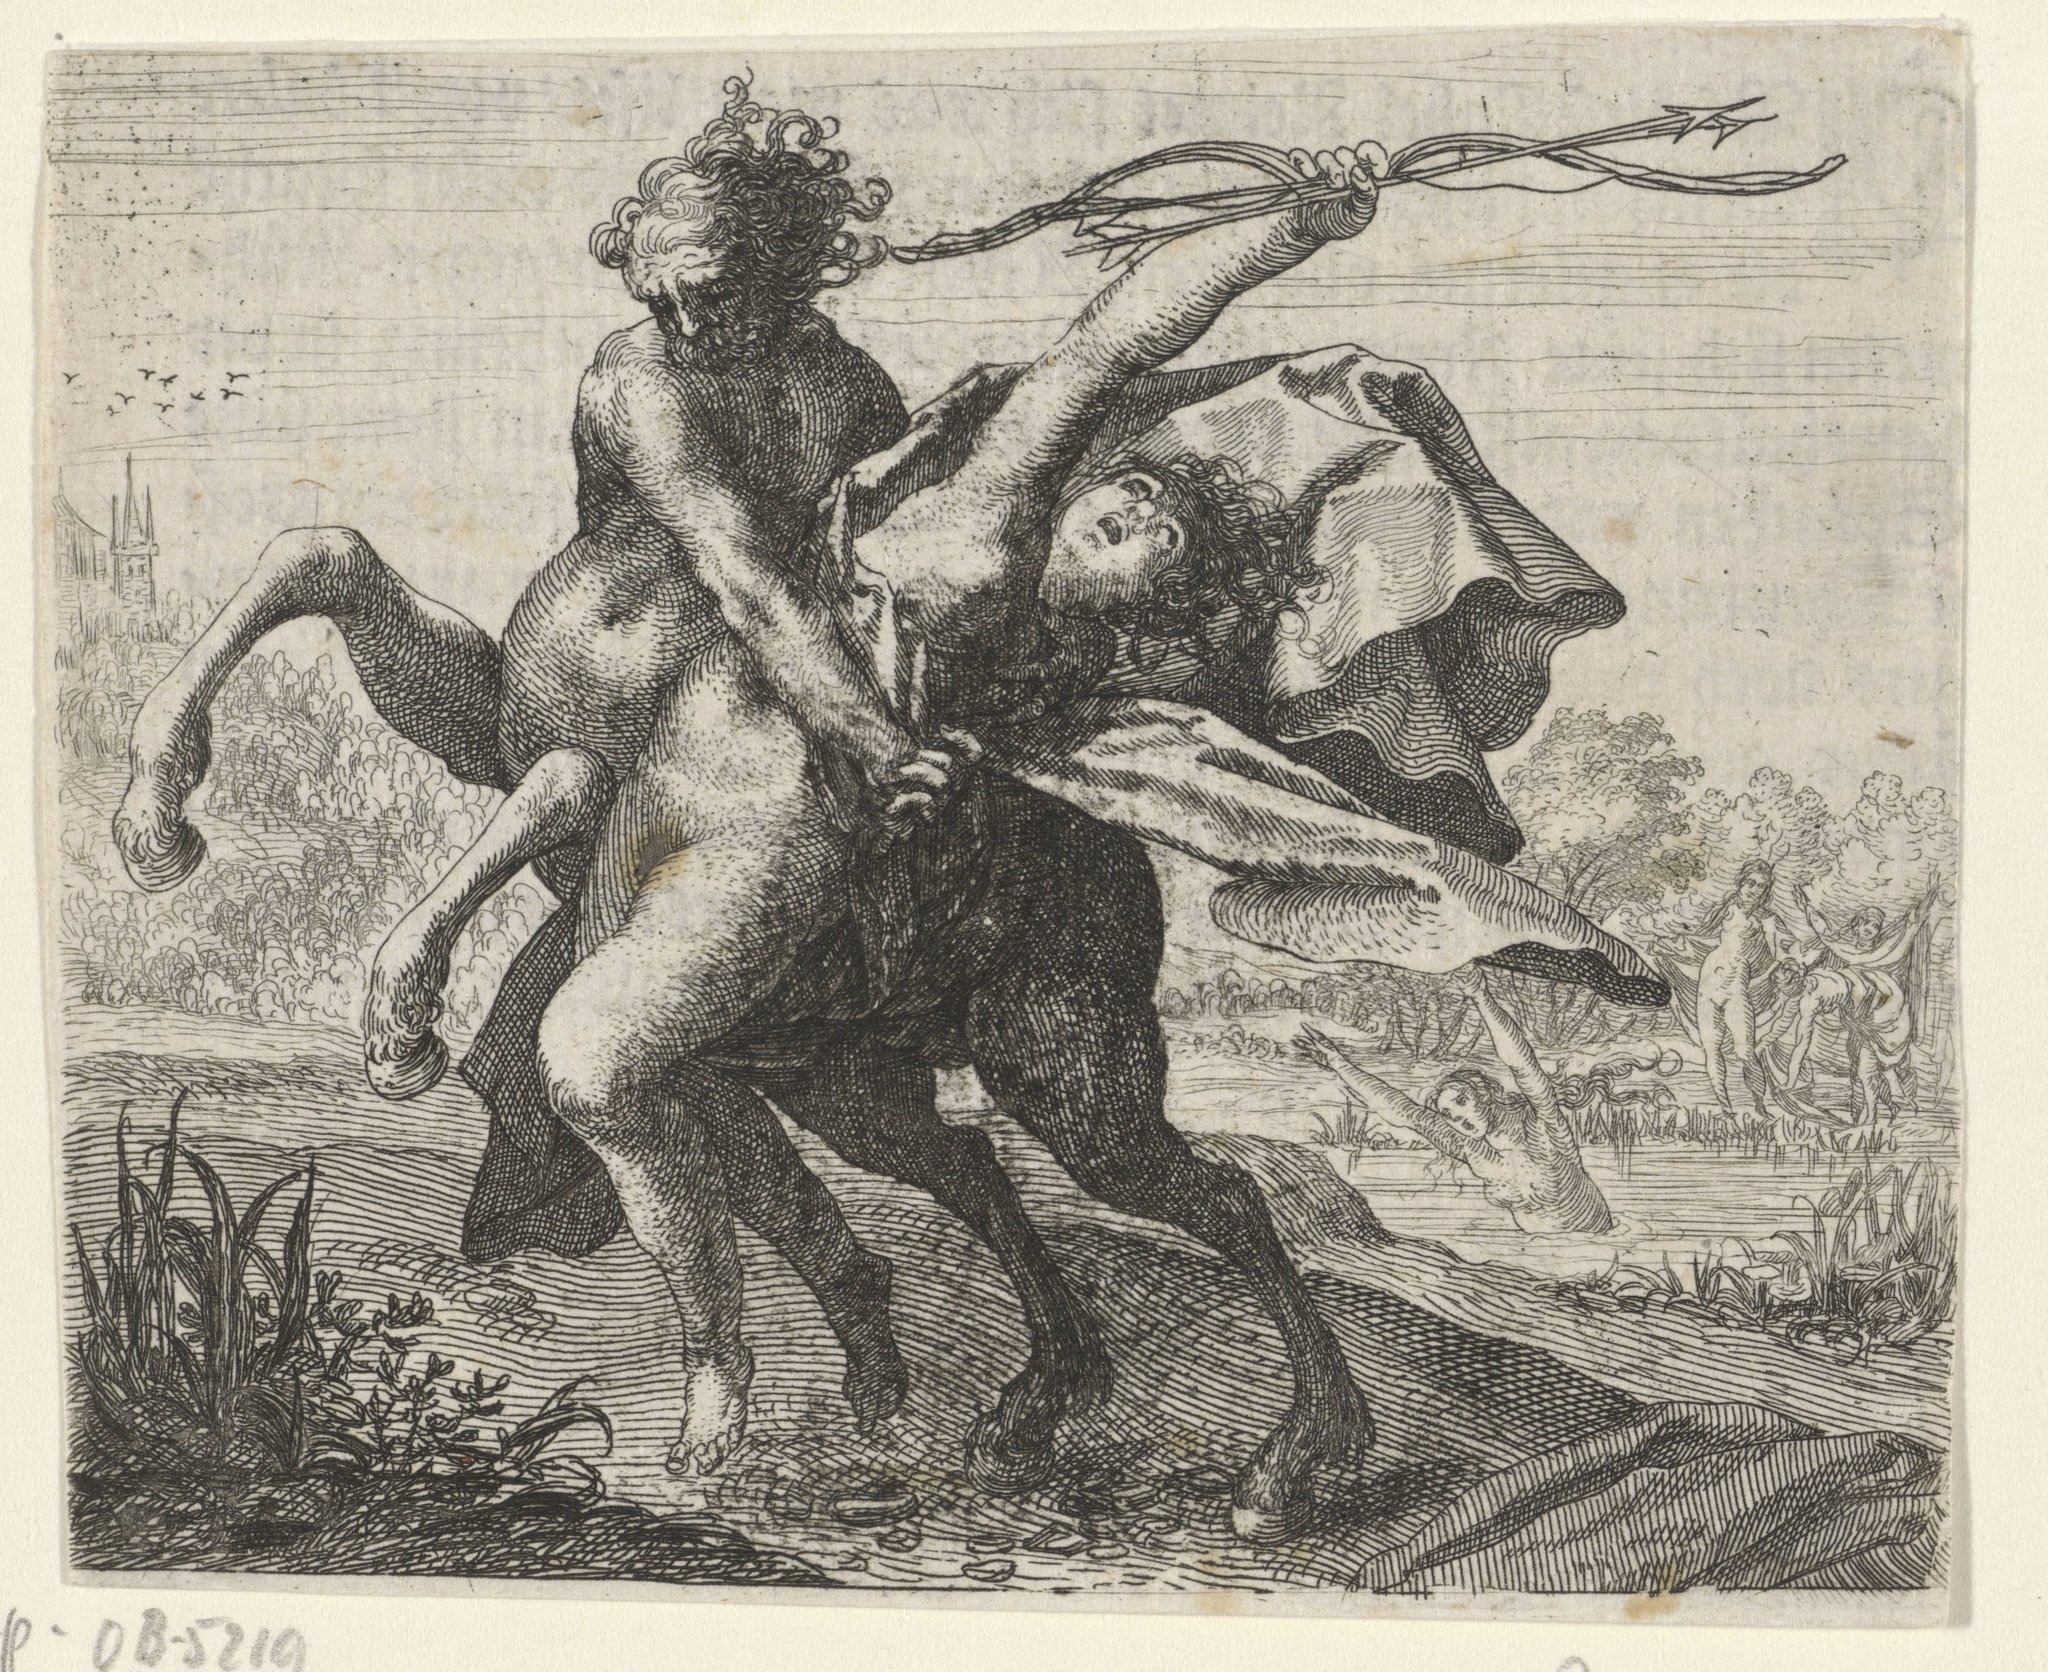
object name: print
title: Fabel van de ontvoering van een vrouw door een centaur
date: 1608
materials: paper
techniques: engraving, etching, letterpress printing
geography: prague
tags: fables, centaurs (+ aggressive, unfriendly activities and relationships), man abducting woman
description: Een centaur ontvoert een naakte vrouw terwijl ze aan het baden is. In de achtergrond de andere badende vrouwen in een vijver. De moraal van het verhaal leert dat het beter is te sterven dan in schande te leven